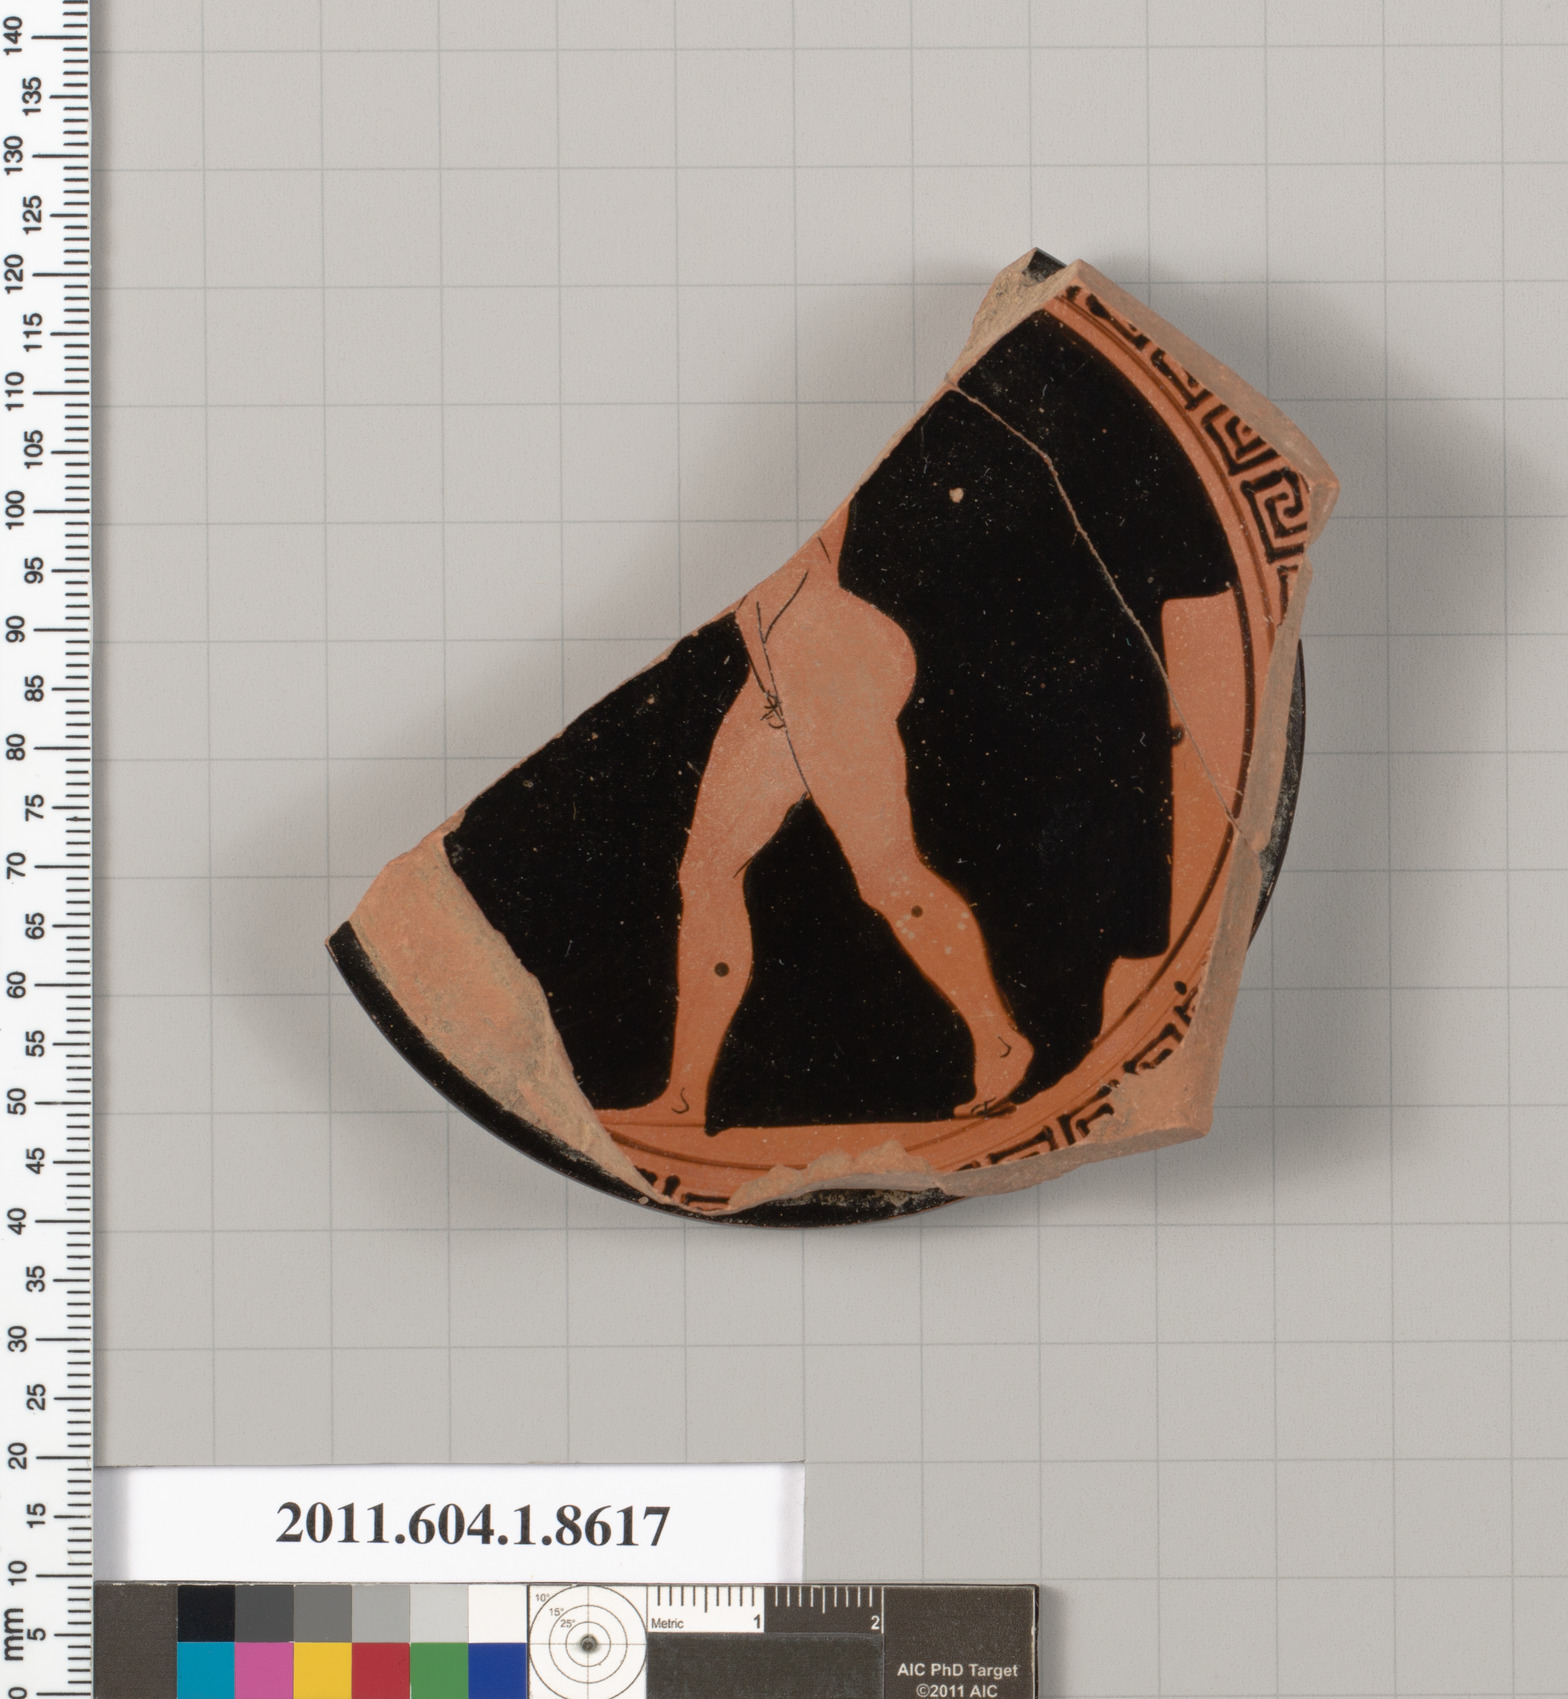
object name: kylix fragment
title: Terracotta fragment of a stemless kylix (drinking cup)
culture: greek, attic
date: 460-450 BCE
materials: terracotta